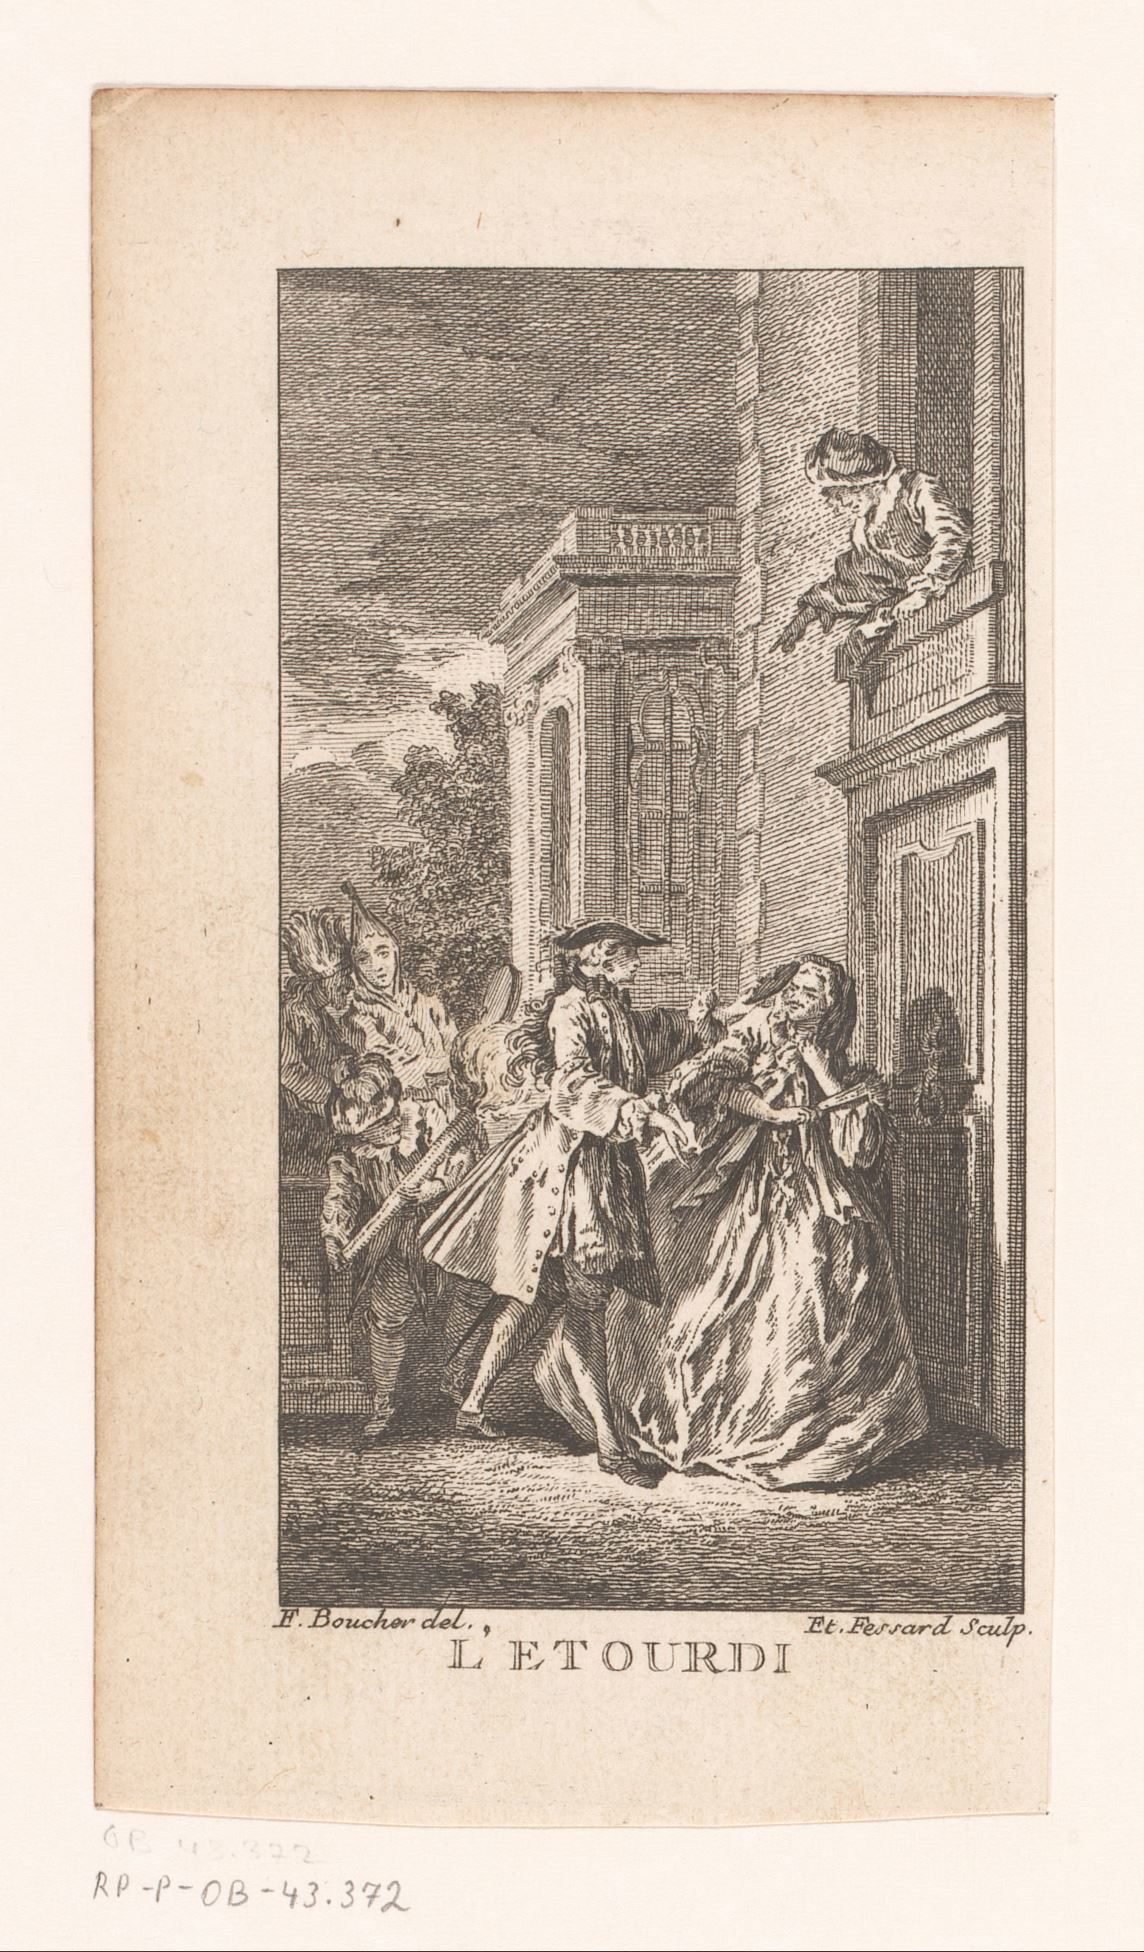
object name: print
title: L'etourdi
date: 1749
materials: paper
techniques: etching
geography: paris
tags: adult woman, adult man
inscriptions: collector's mark: Lugt 2228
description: Prent uit: Molière. Œuvres. Parijs: Les libraires associés, 1749.